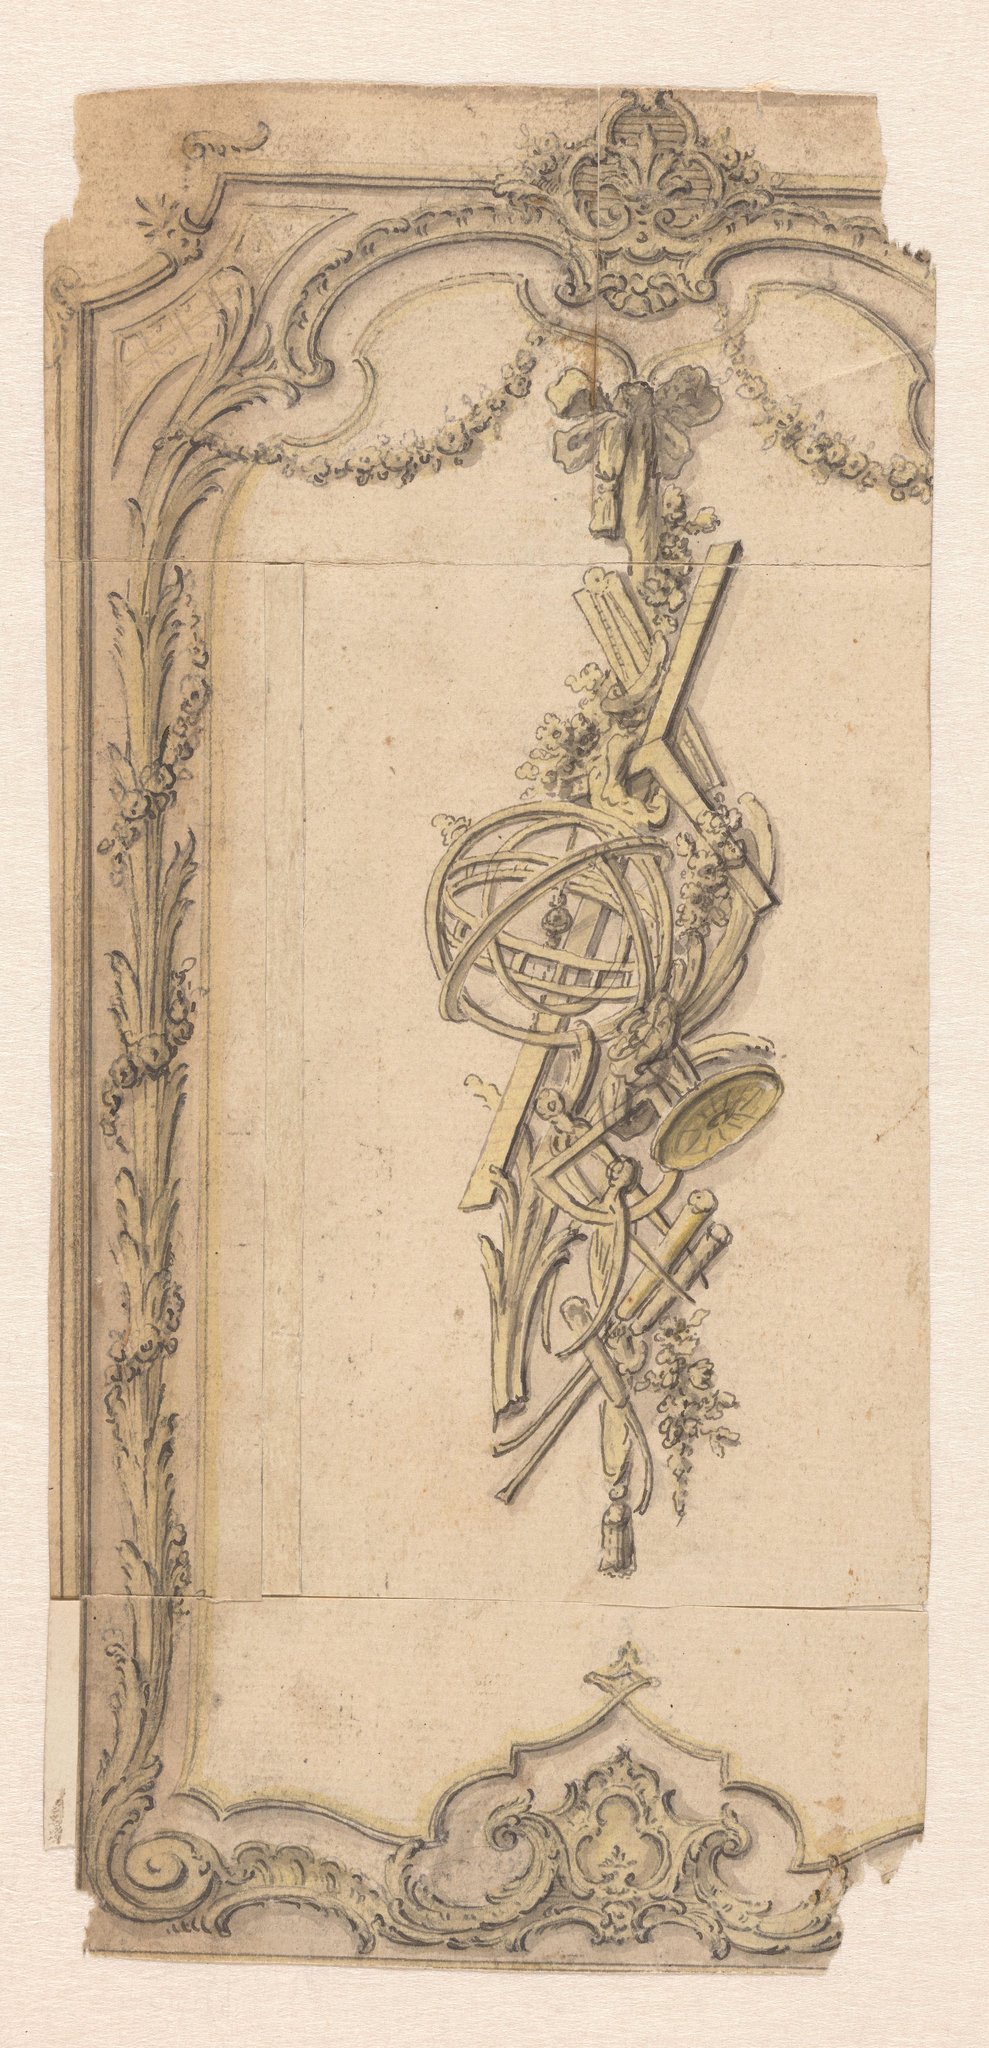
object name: design drawing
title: Ontwerp voor een gebeeldhouwd wandpaneel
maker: Anonymous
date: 1735-1755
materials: graphite, ink, paper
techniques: pen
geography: paris